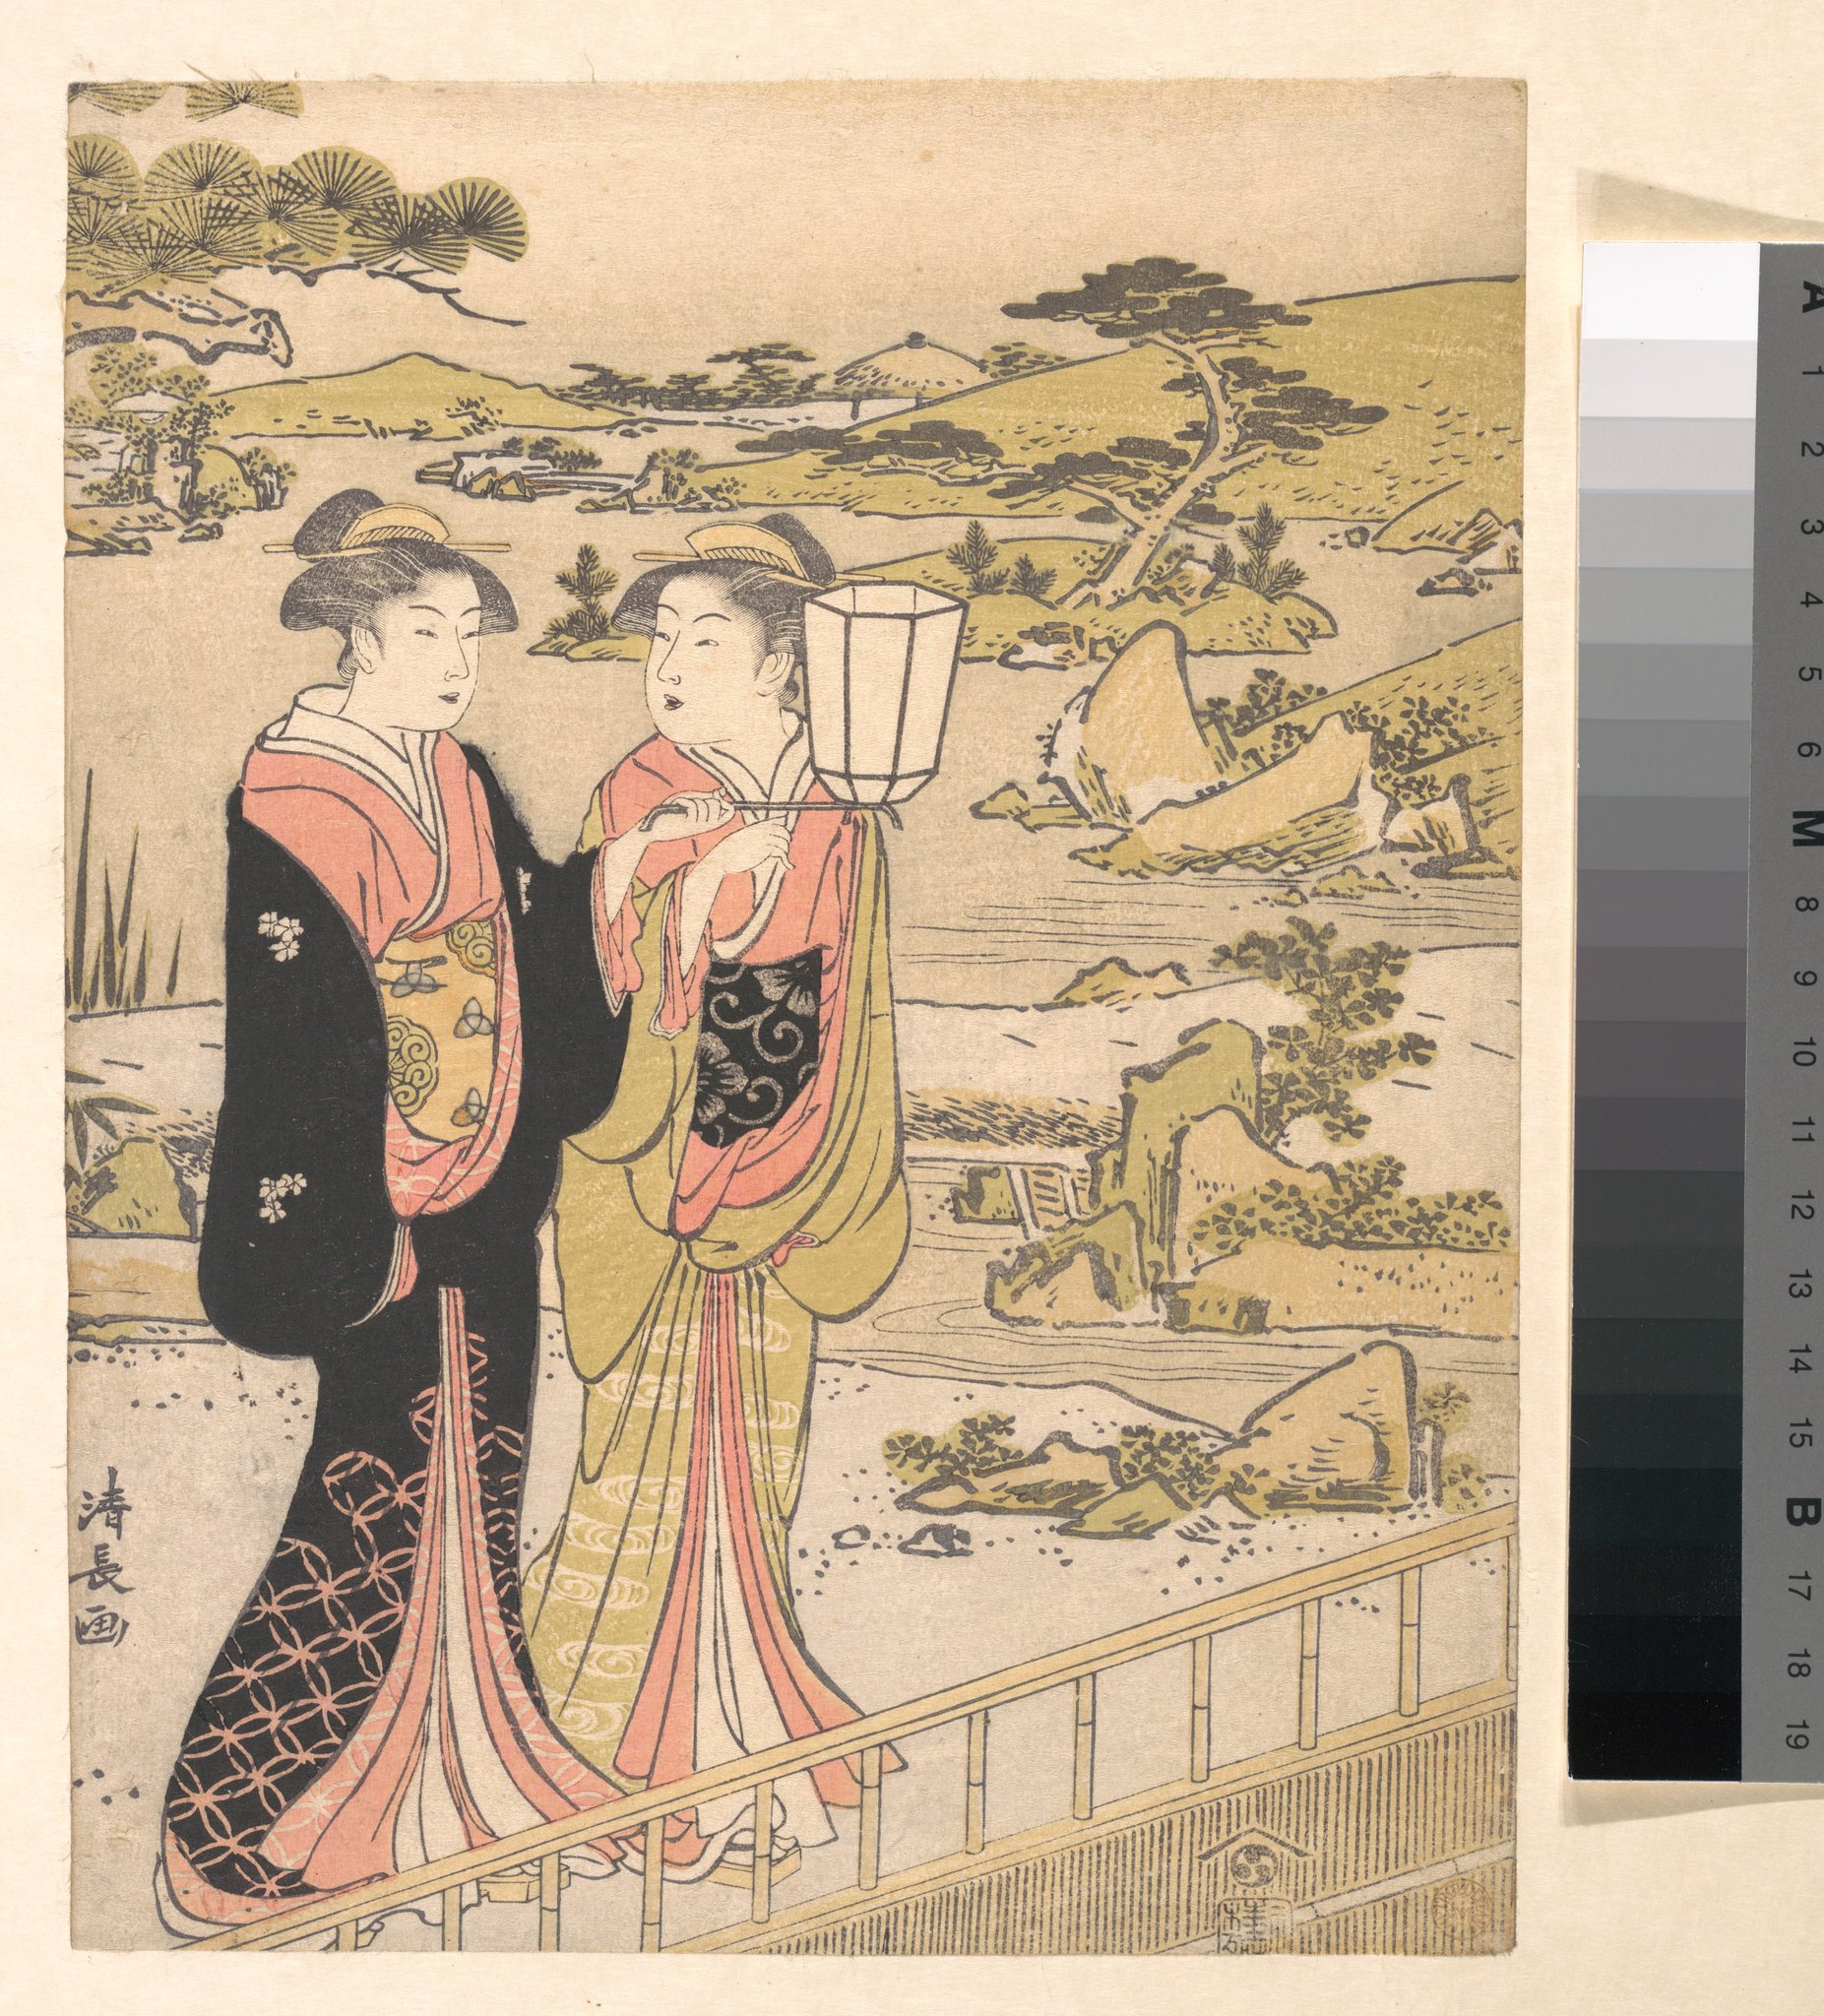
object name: print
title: Two Women in a Garden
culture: japanese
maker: torii kiyonaga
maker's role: artist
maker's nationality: japanese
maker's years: 1752-1815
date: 1789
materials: ink, paper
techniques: woodblock print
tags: gardens,women,landscapes